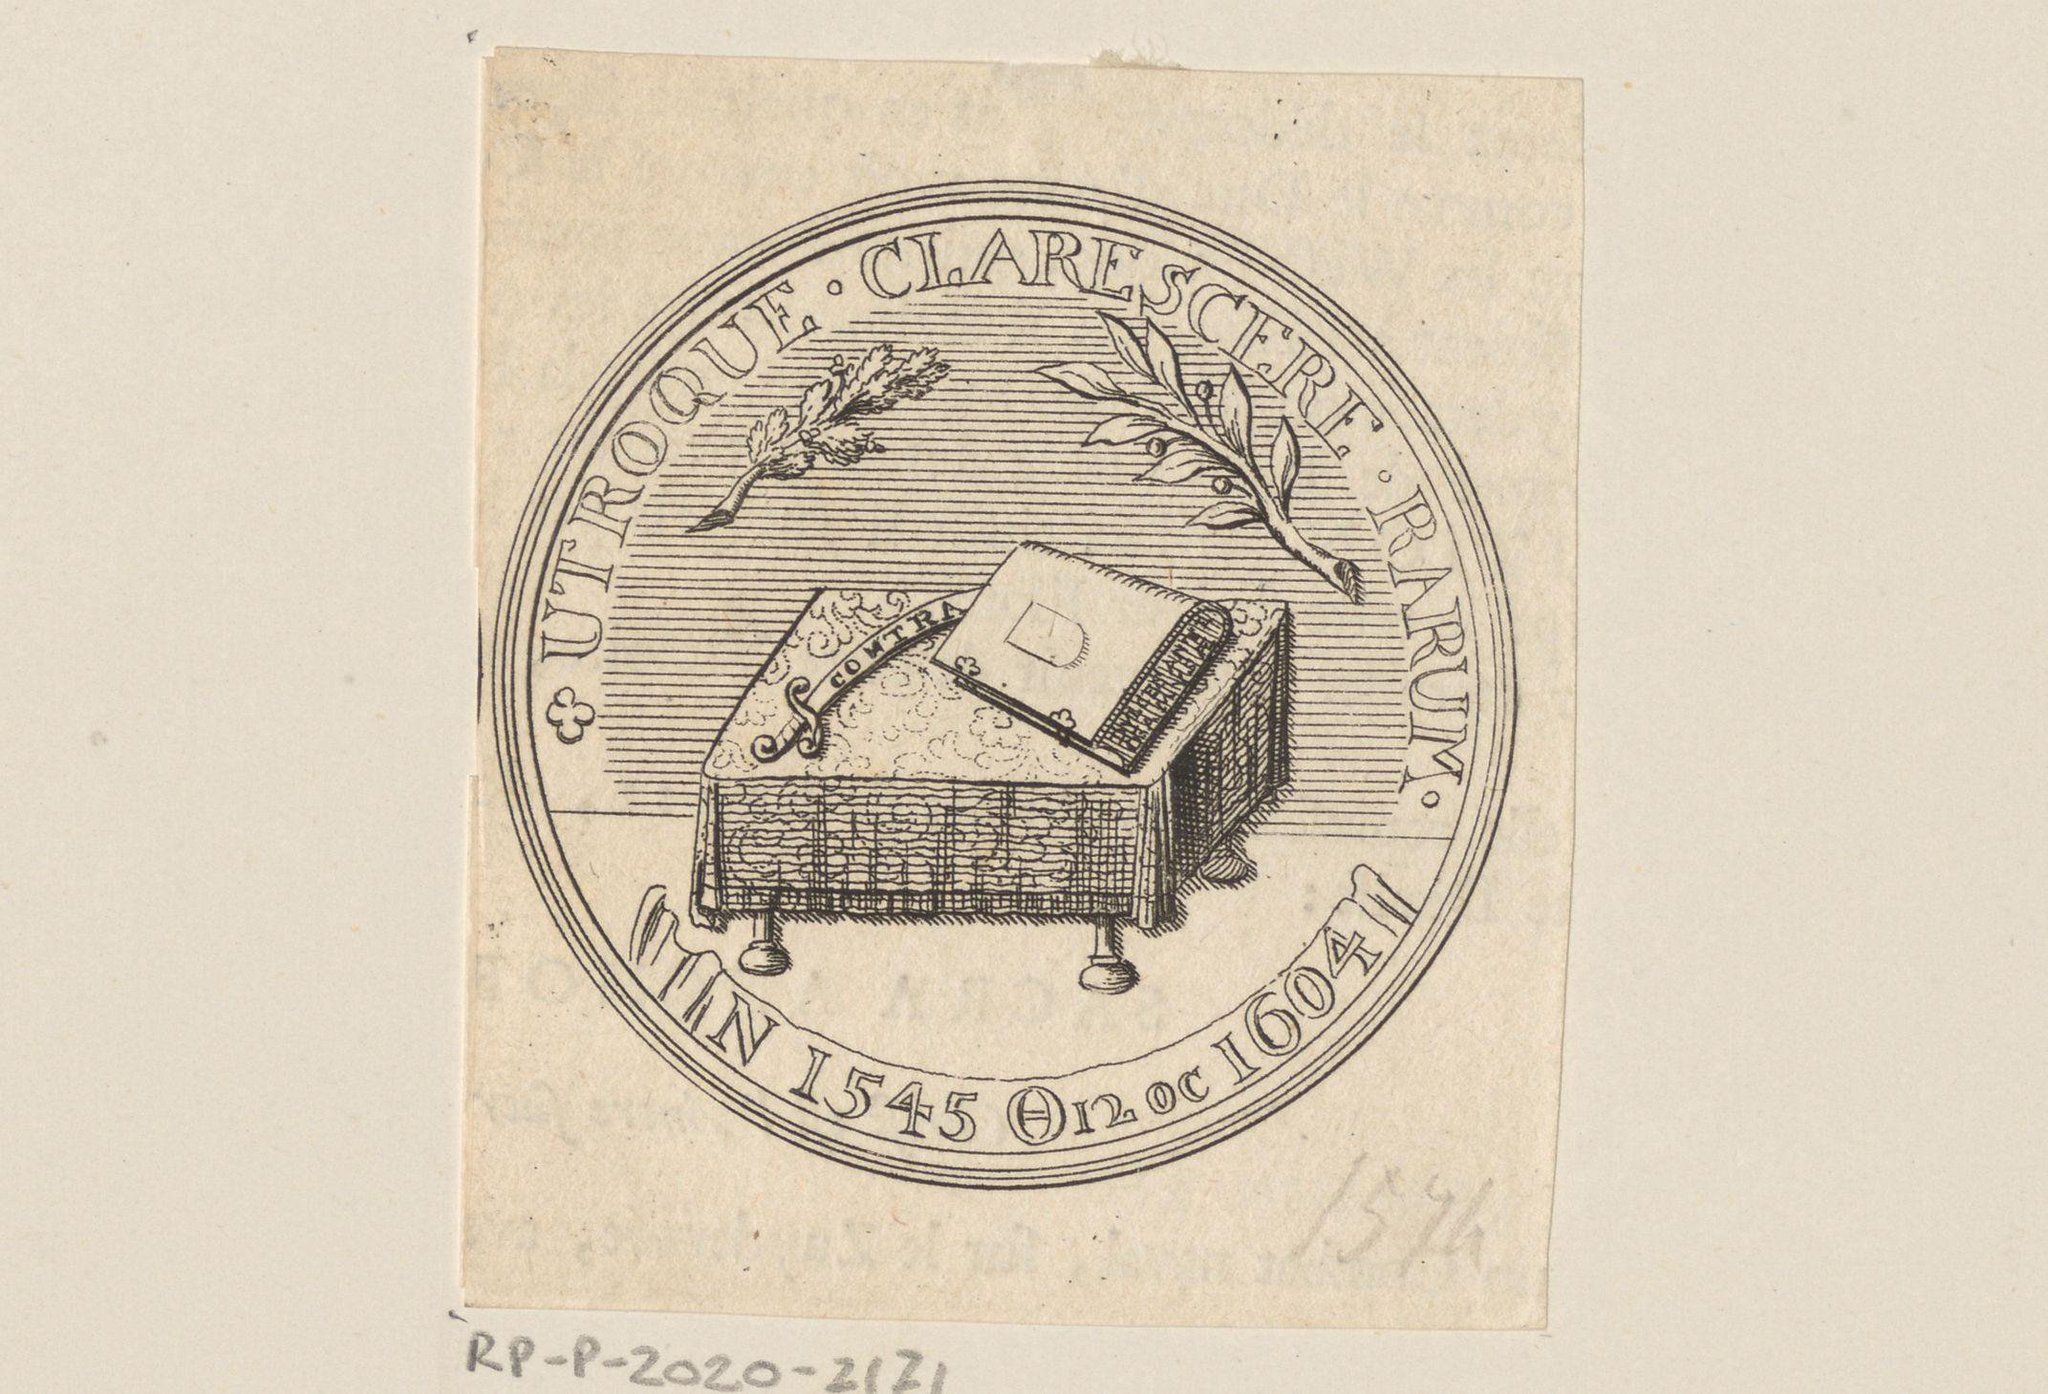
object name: book illustration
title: Medaillon met de attributen van Jan van der Does, heer van Noordwijk en Kattendijke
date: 1736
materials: paper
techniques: etching, letterpress printing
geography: amsterdam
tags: memorial medal, hacking and thrusting weapons: sword, book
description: Prent uit: Explication historique des principales medailles (...). Amsterdam: Zacharias Chatelain, 1736. Deze prent is gemaakt naar een gedenkpenning voor de verdiensten van Jan van der Does. Prent heeft mogelijk deel uitgemaakt van een grotere prent die versneden is.